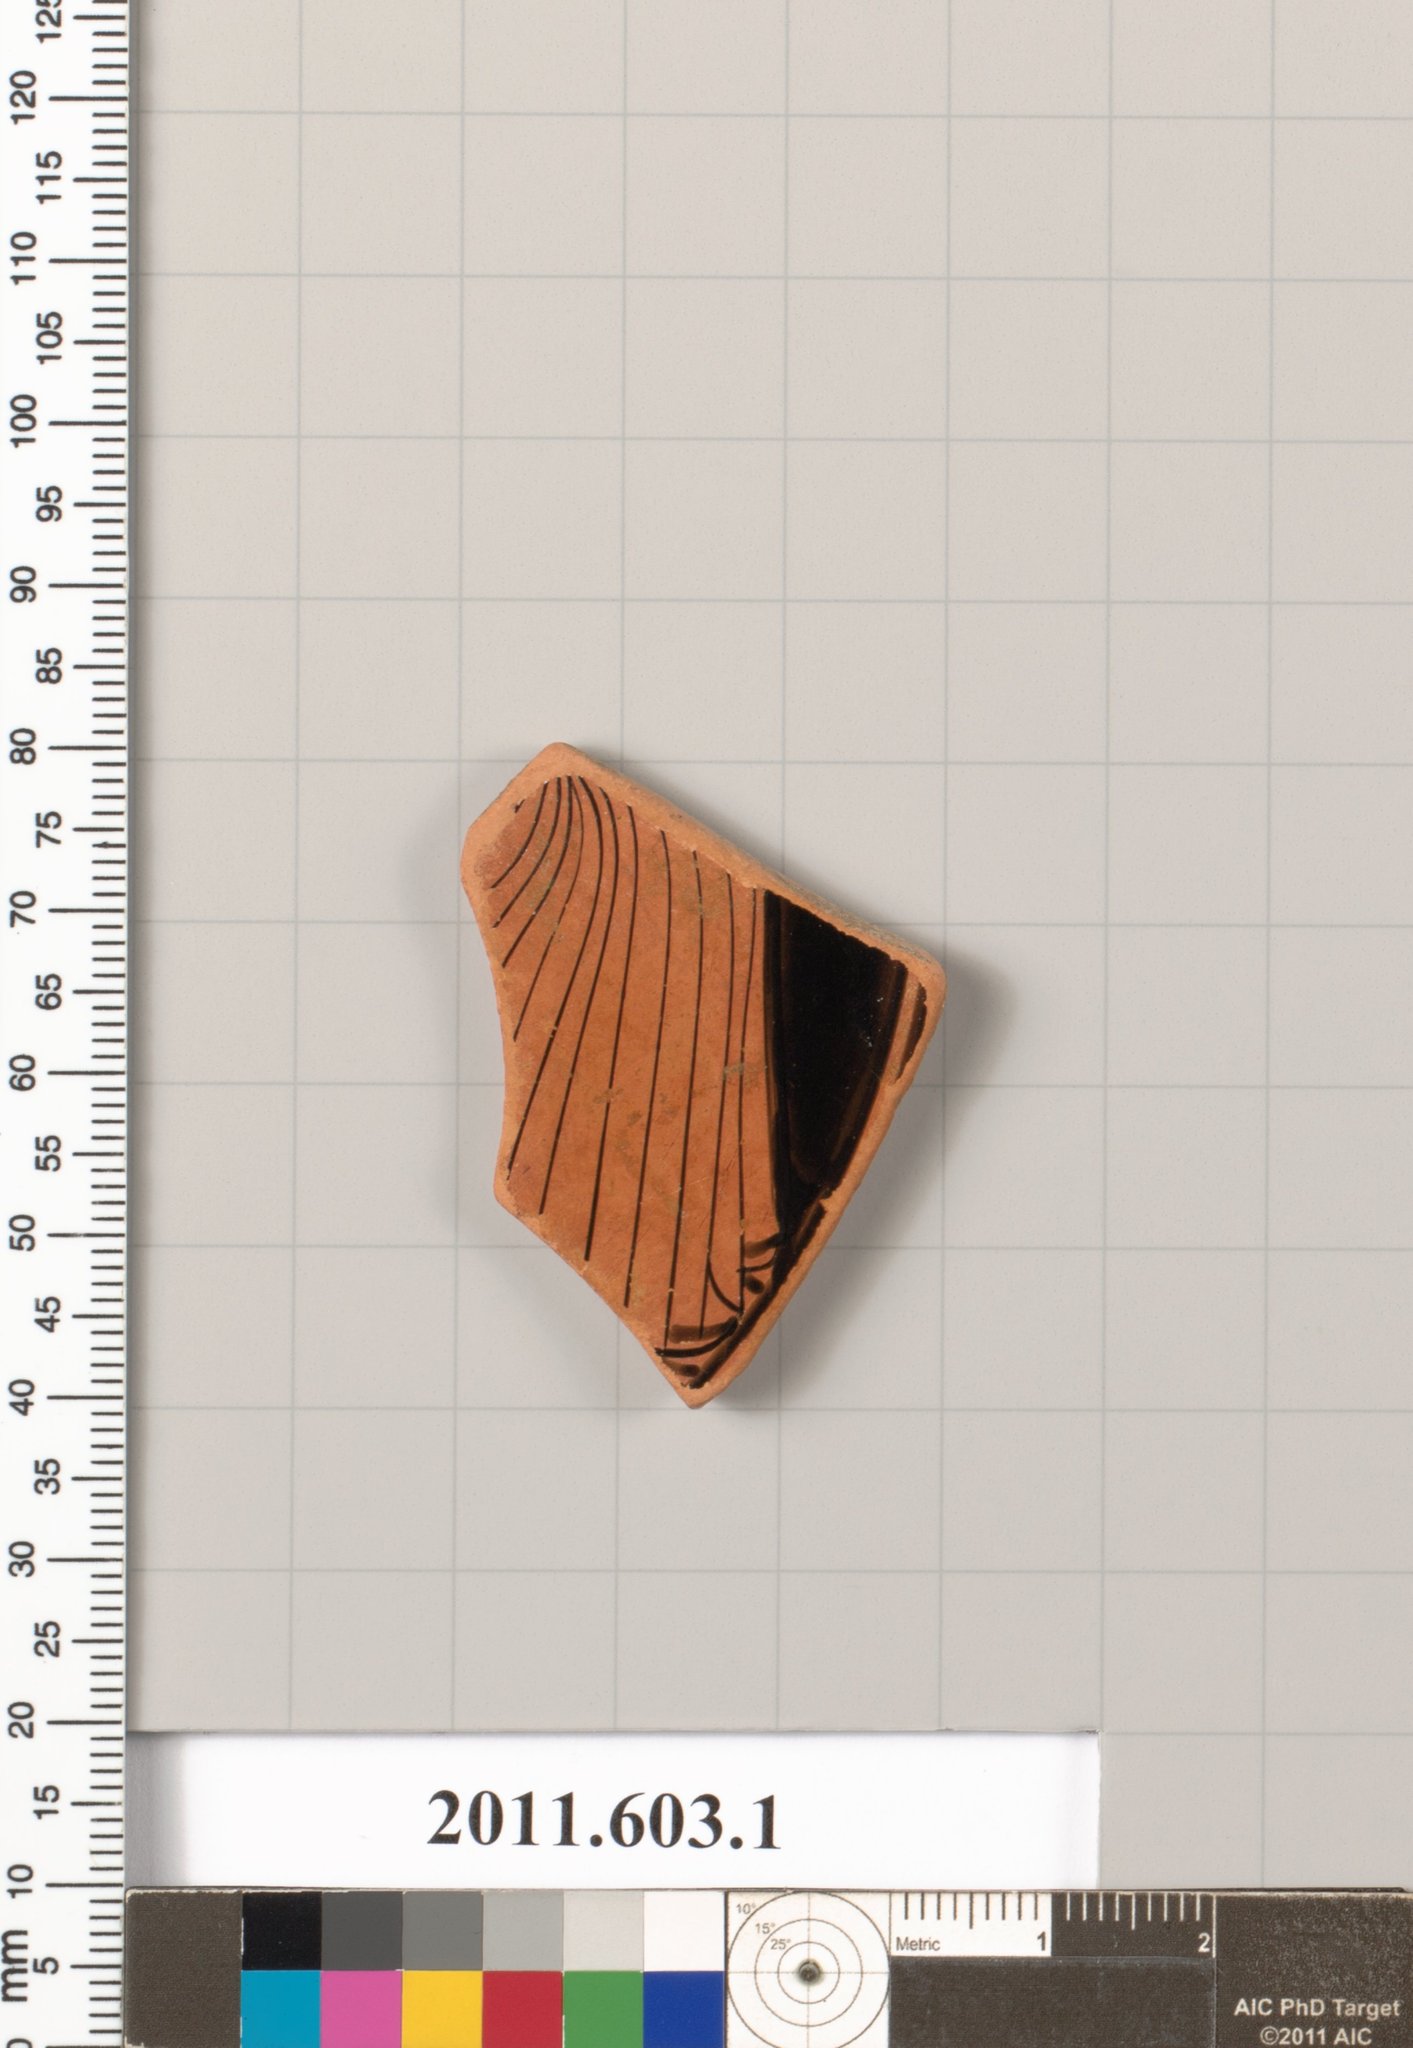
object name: kylix fragment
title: Fragment of a terracotta kylix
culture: greek, attic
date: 480 BCE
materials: terracotta